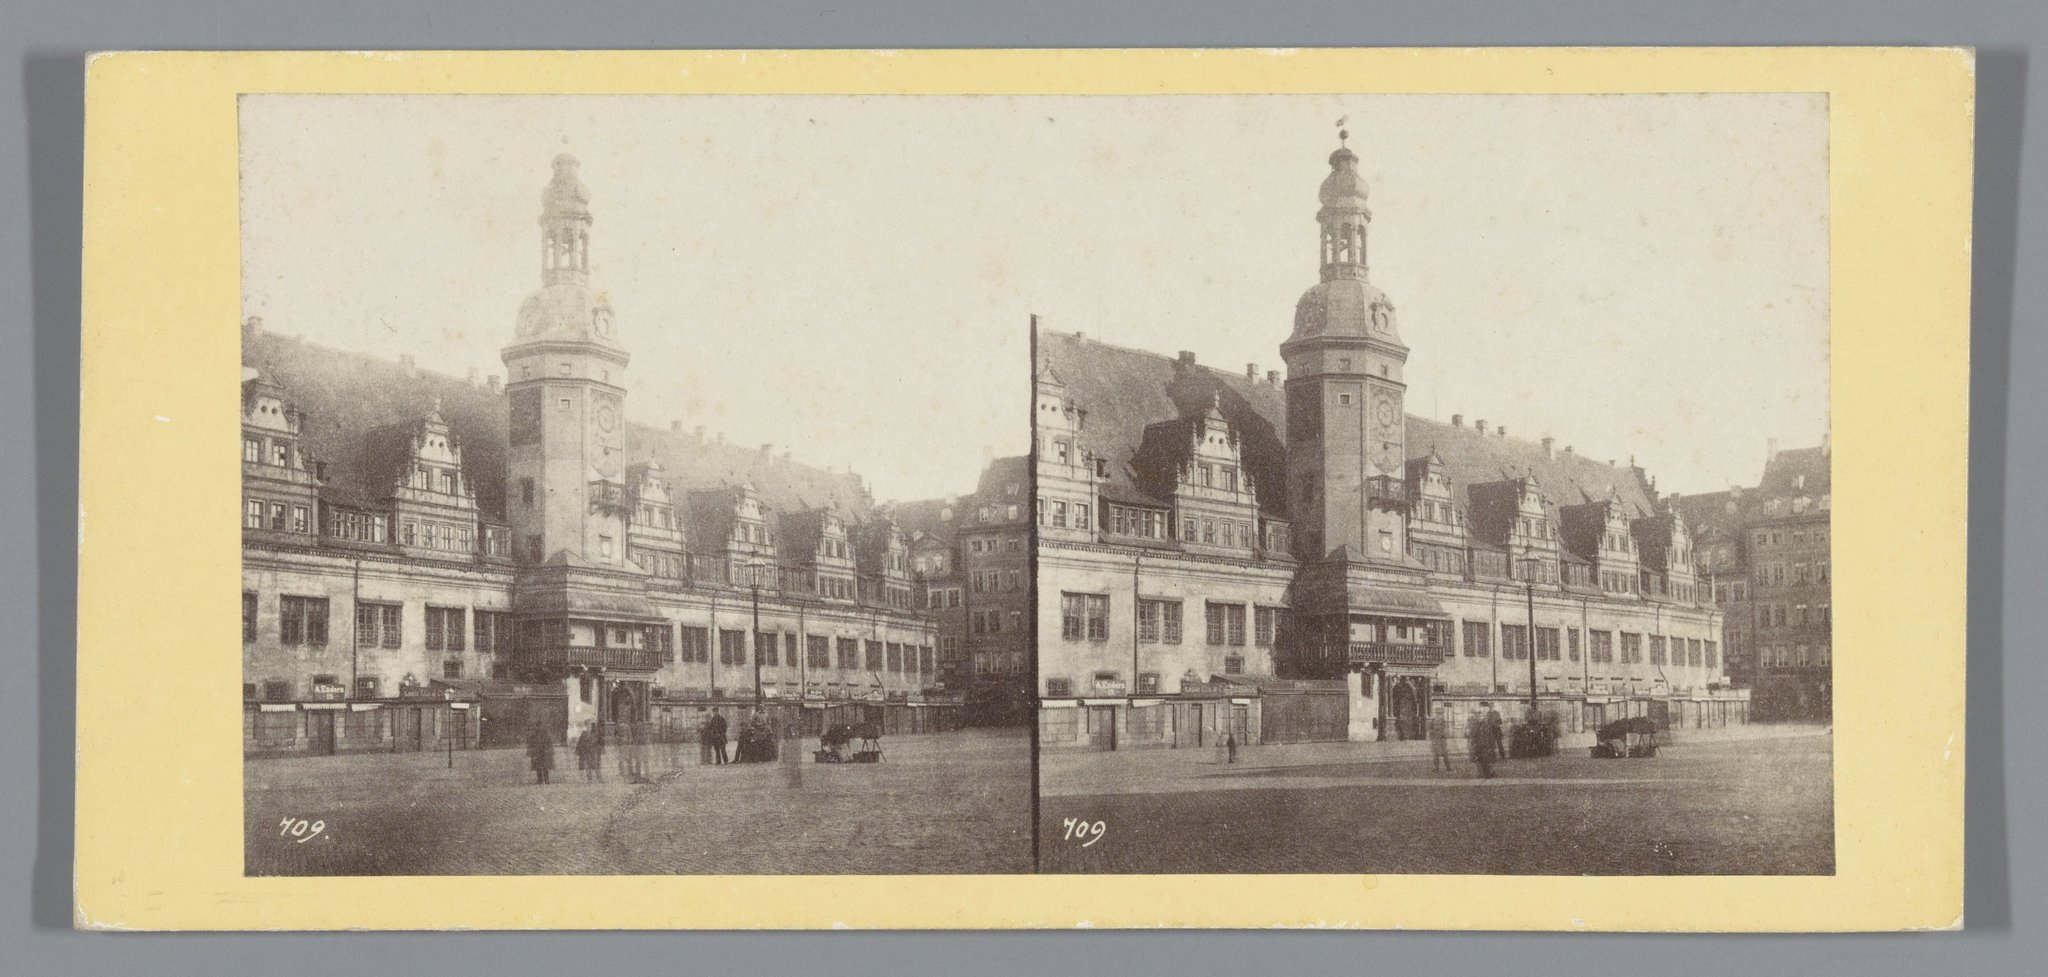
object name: stereograph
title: Leipzig. Rathhaus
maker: Anonymous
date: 1863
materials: cardboard, photographic support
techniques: albumen print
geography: leipzig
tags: townhall, façade (of house or building)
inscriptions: number: ‘709.’